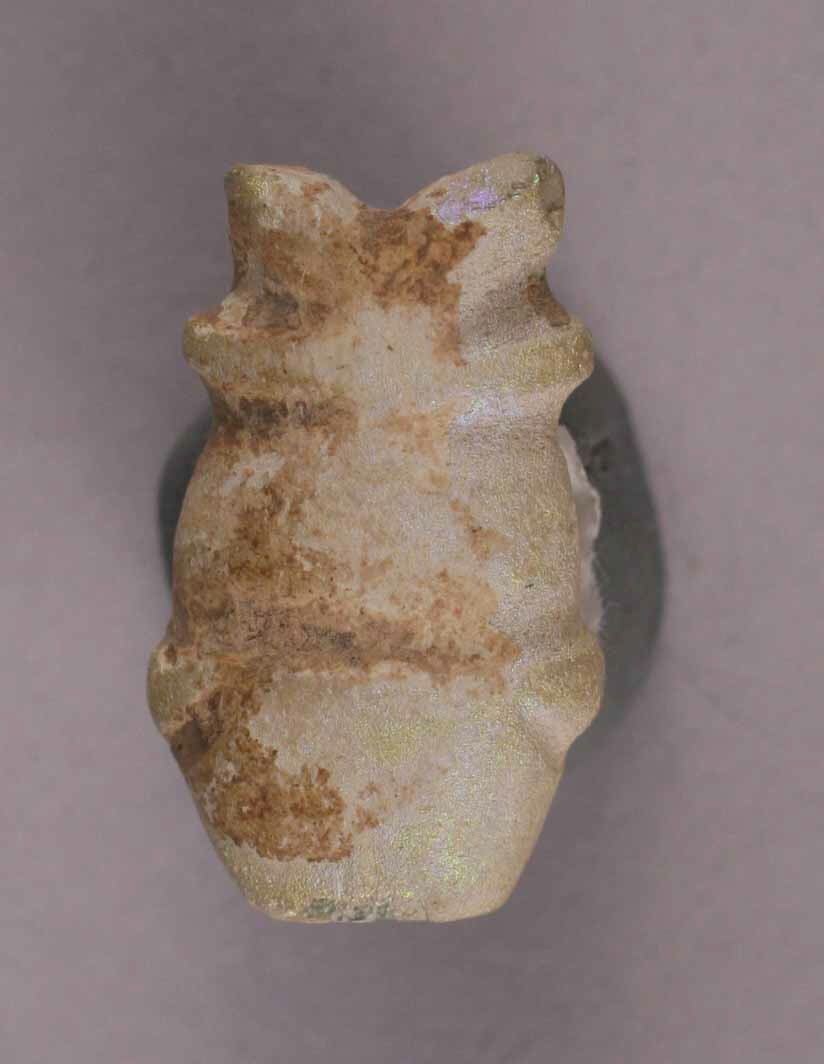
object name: bead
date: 701-1300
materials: glass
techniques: cutting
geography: iran